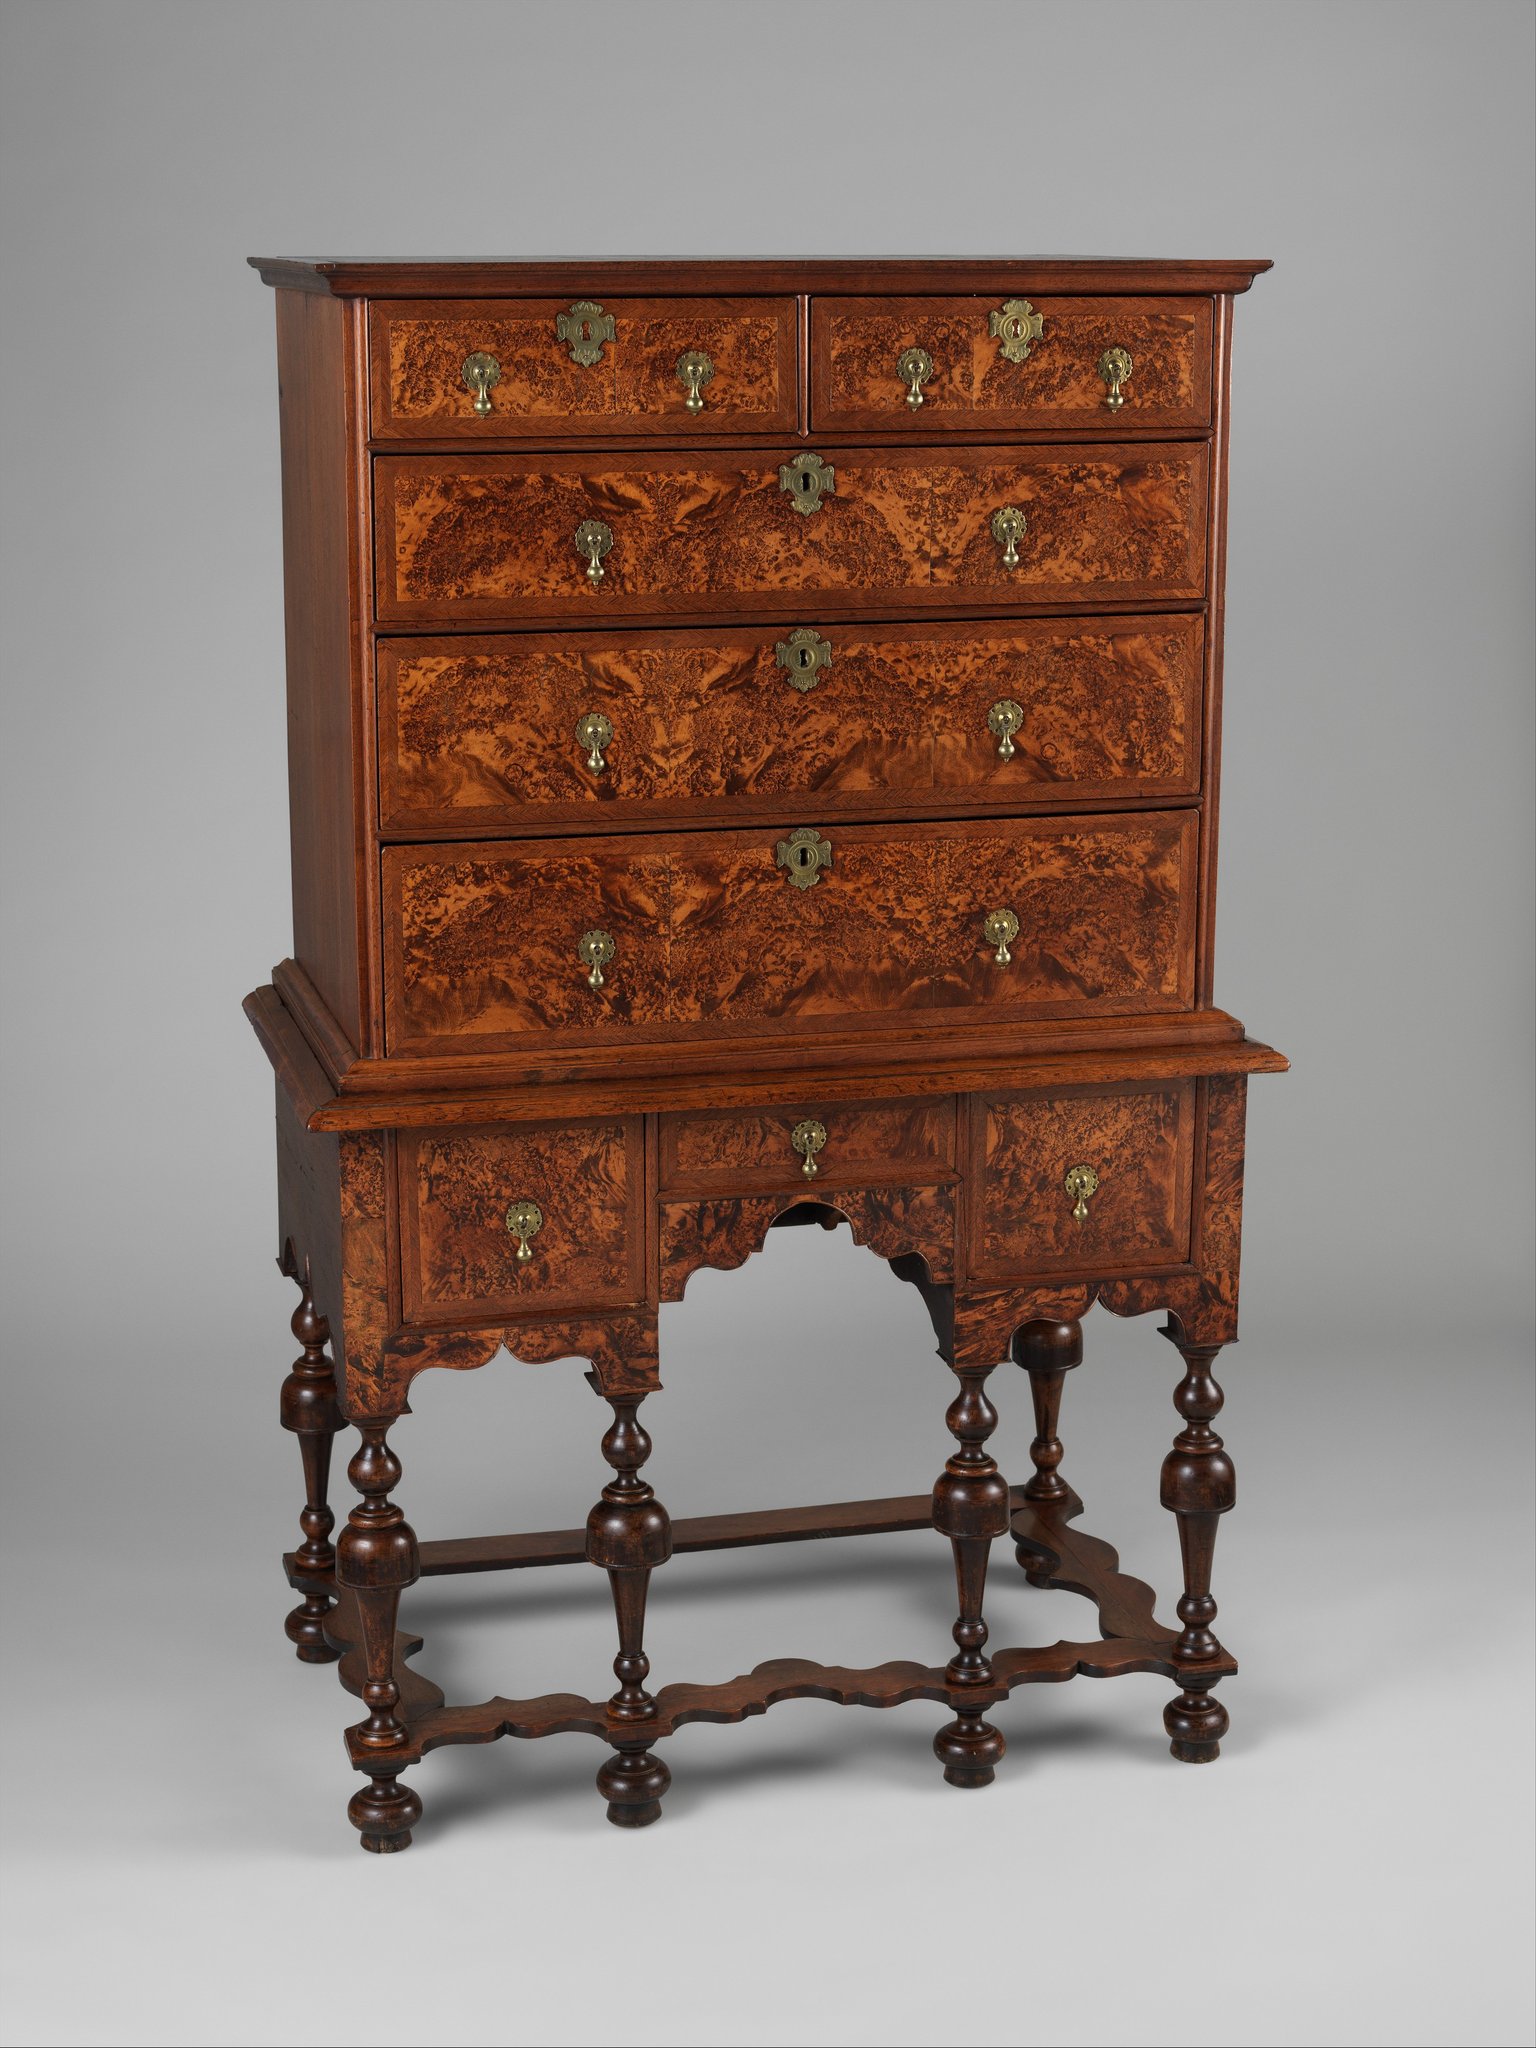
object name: high chest of drawer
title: High chest of drawers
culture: american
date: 1700-1730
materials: wood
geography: united states